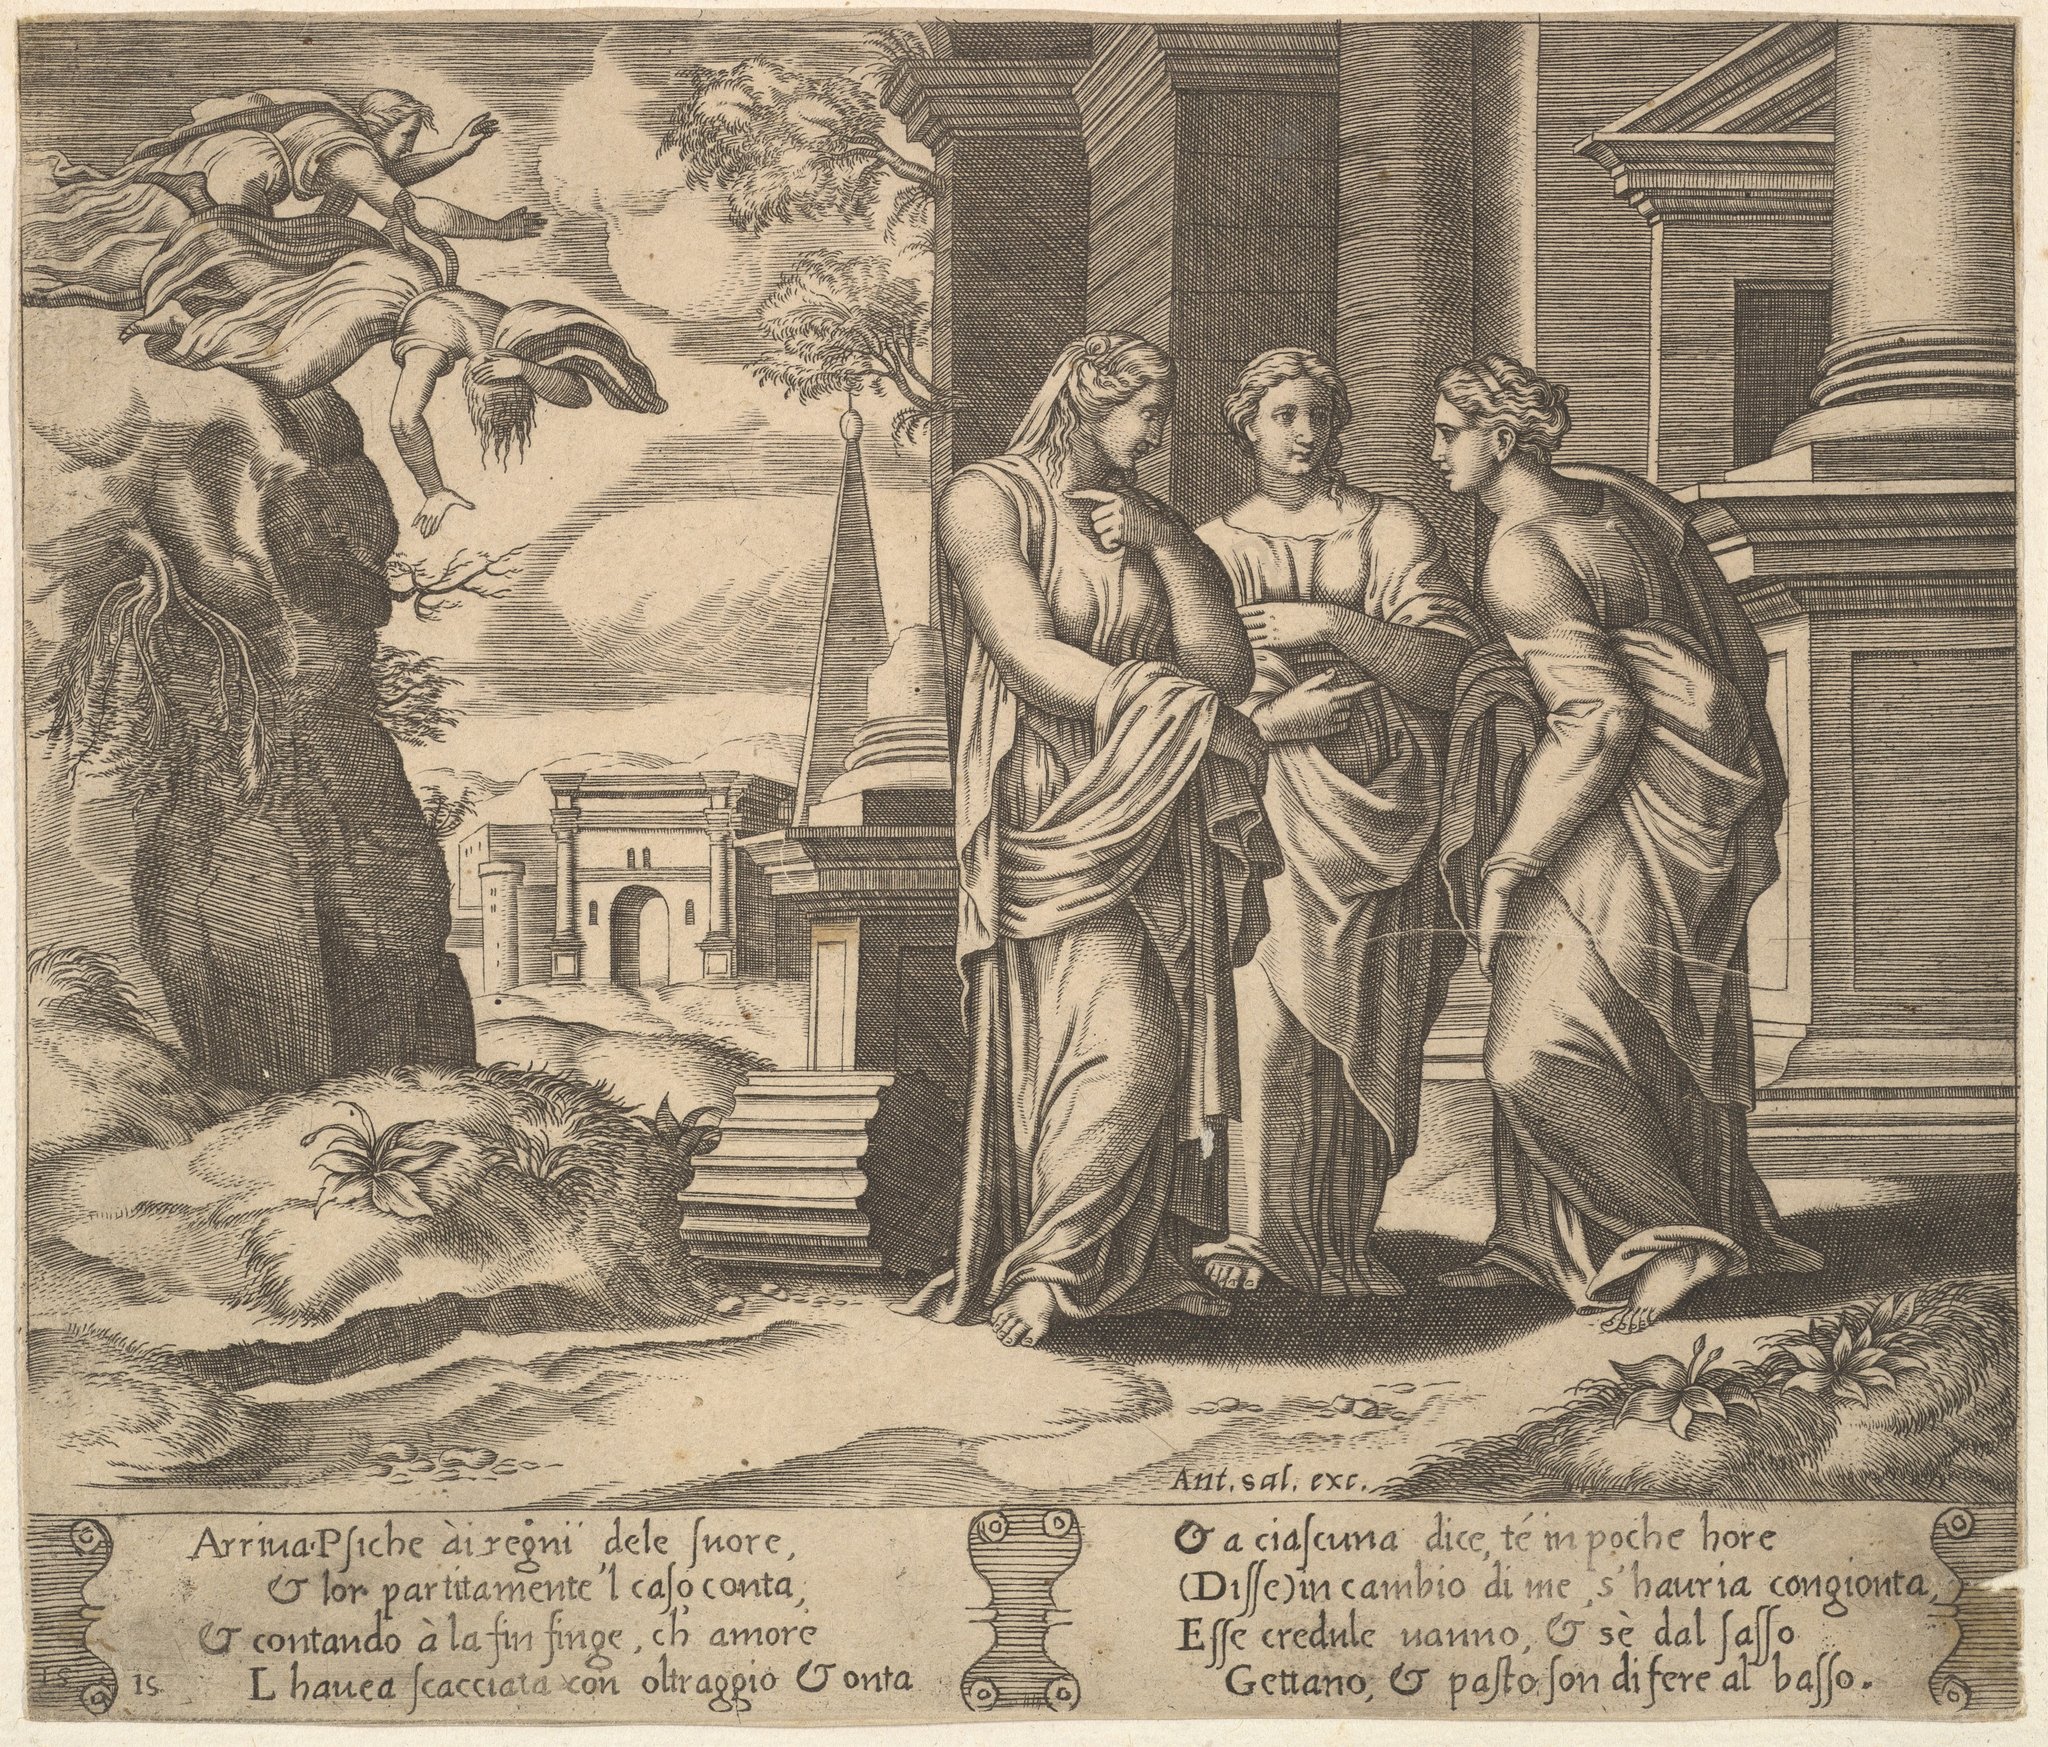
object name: print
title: Plate 15: Psyche relating her misfortunes to her sisters, from "The Fable of Cupid and Psyche"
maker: master of the die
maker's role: artist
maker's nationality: italian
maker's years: 1525-1560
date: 1530-1560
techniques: engraving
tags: buildings,women,psyche